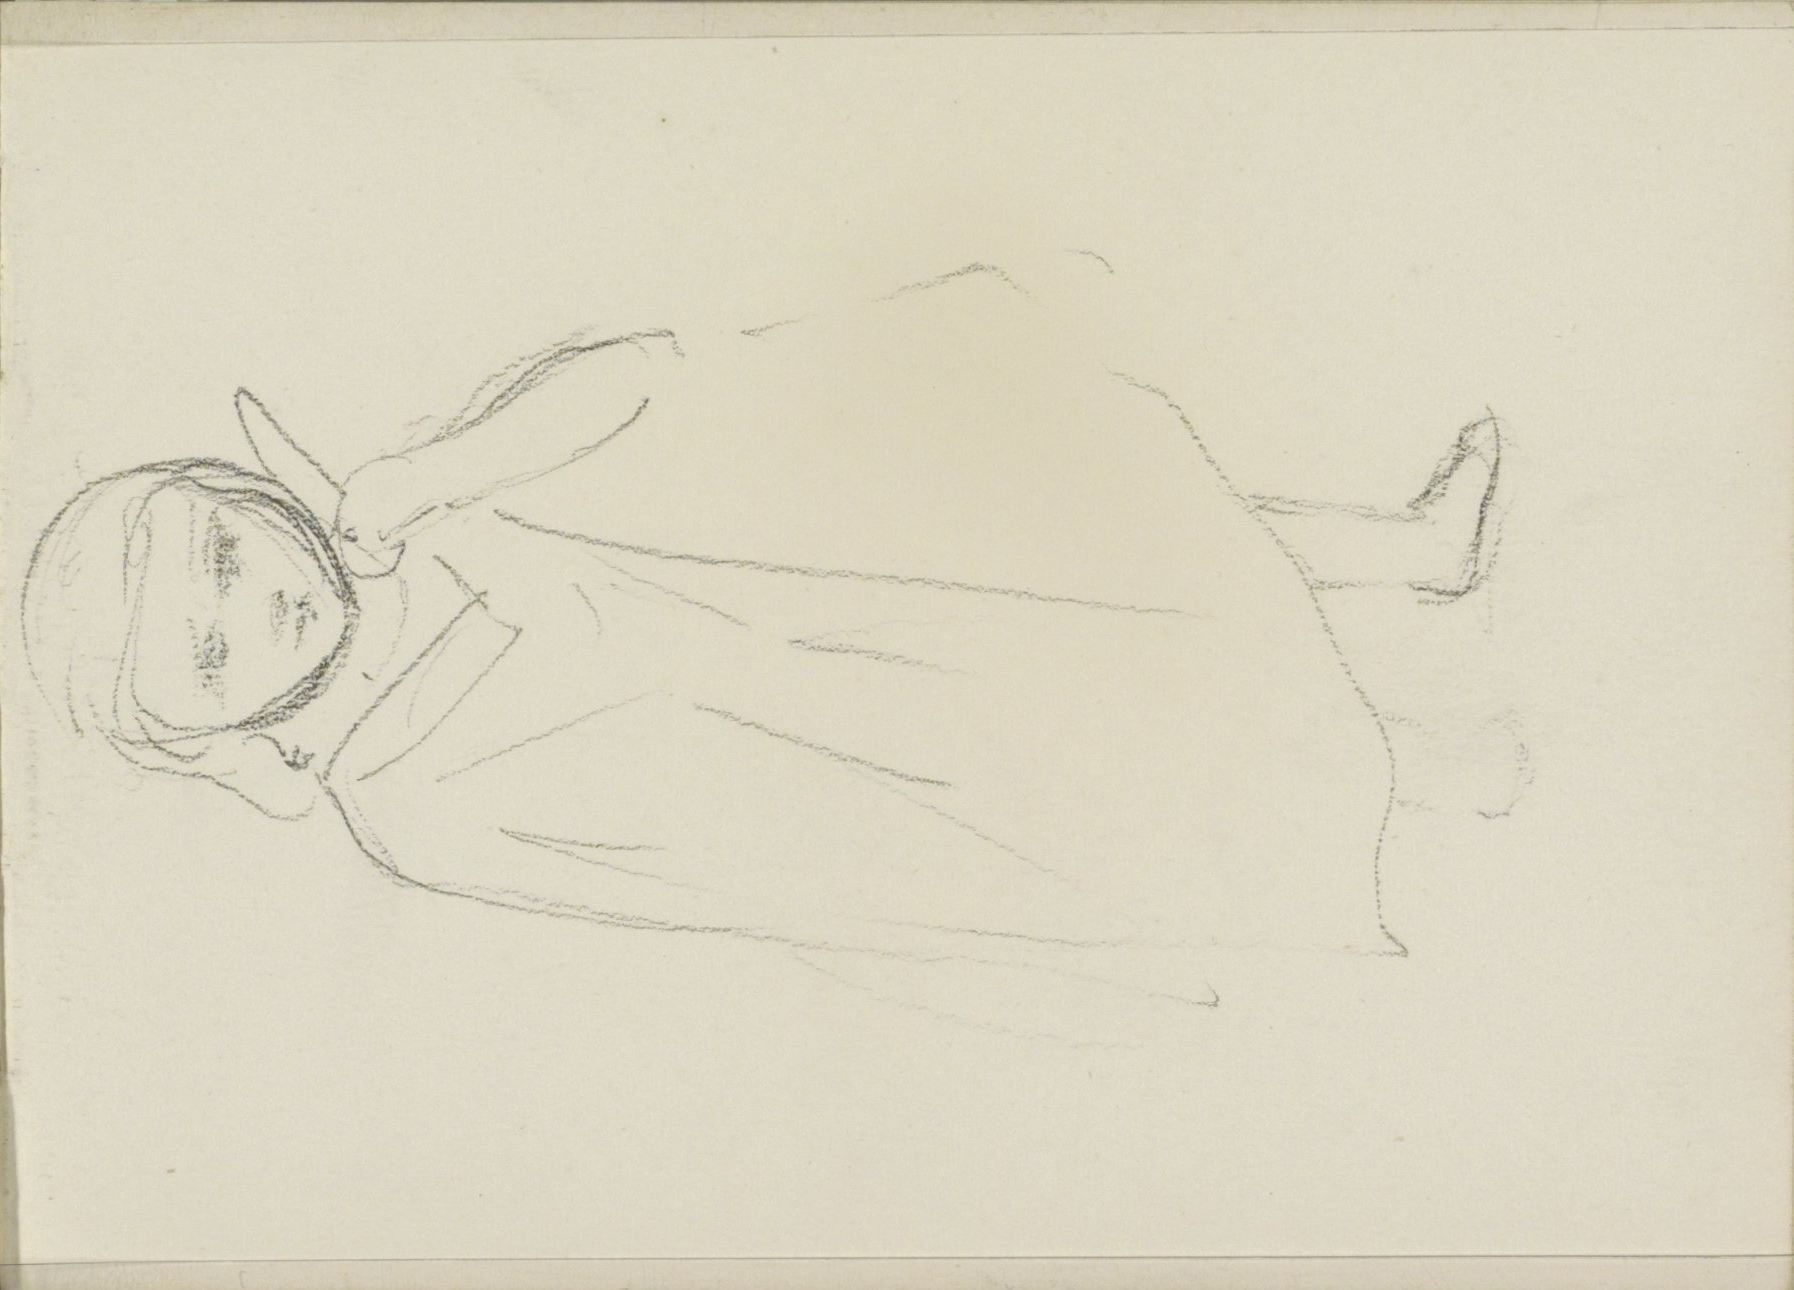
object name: sketchbook leaf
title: Meisje in een mantel met kap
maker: a.a.l. de grammont-hubrecht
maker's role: draughtsman, painter, print maker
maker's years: 1855-1913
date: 1865-1913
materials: chalk, paper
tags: coat (+ girls' clothes), girl (child between toddler and youth)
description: Blad 9 recto uit een schetsboek met 38 bladen.